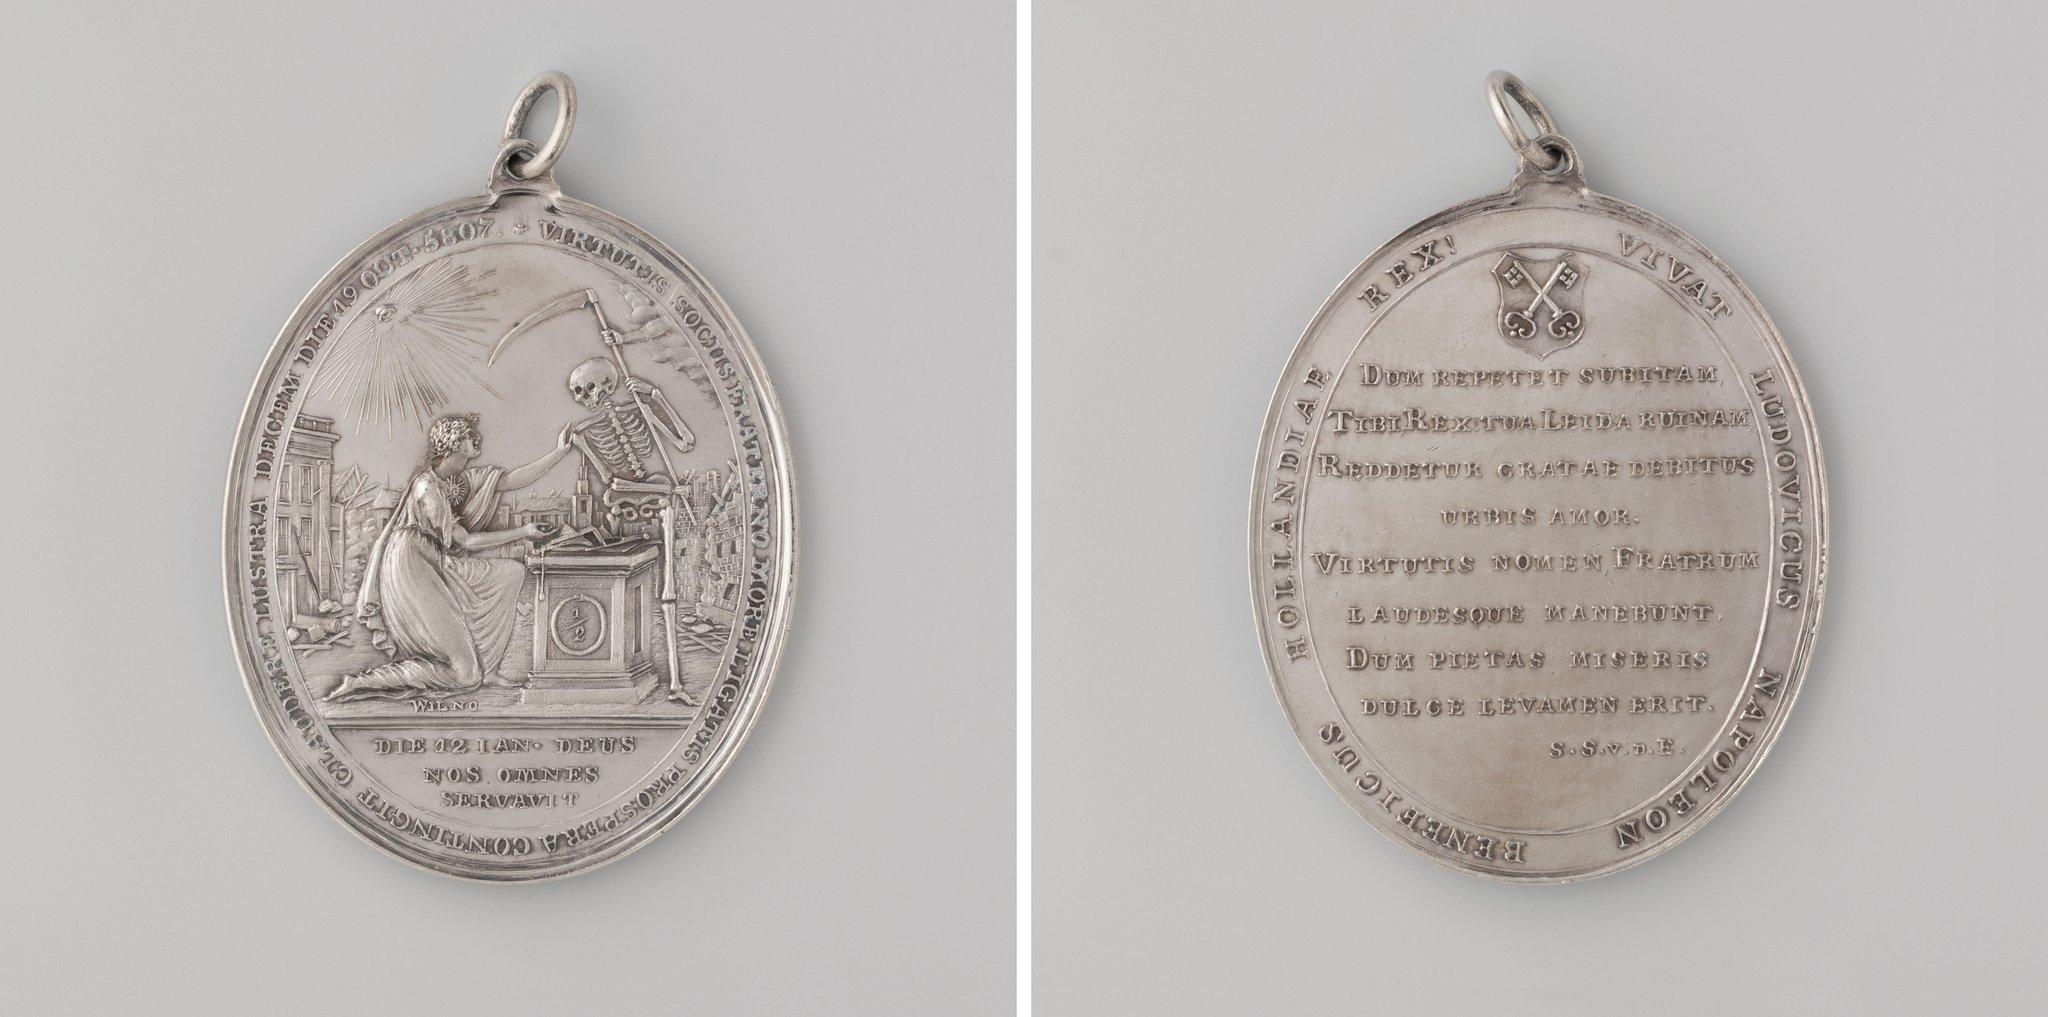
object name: history medal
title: Vijftigjarig bestaan der vrijmetselaarsloge "La Vertu" te Leiden, ter herinnering aan de ontploffing van de kruitboot aan de Rapenburg te Leiden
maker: wilno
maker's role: medailleur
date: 1807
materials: silver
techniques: striking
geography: the hague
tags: louis napoleon (king of holland)